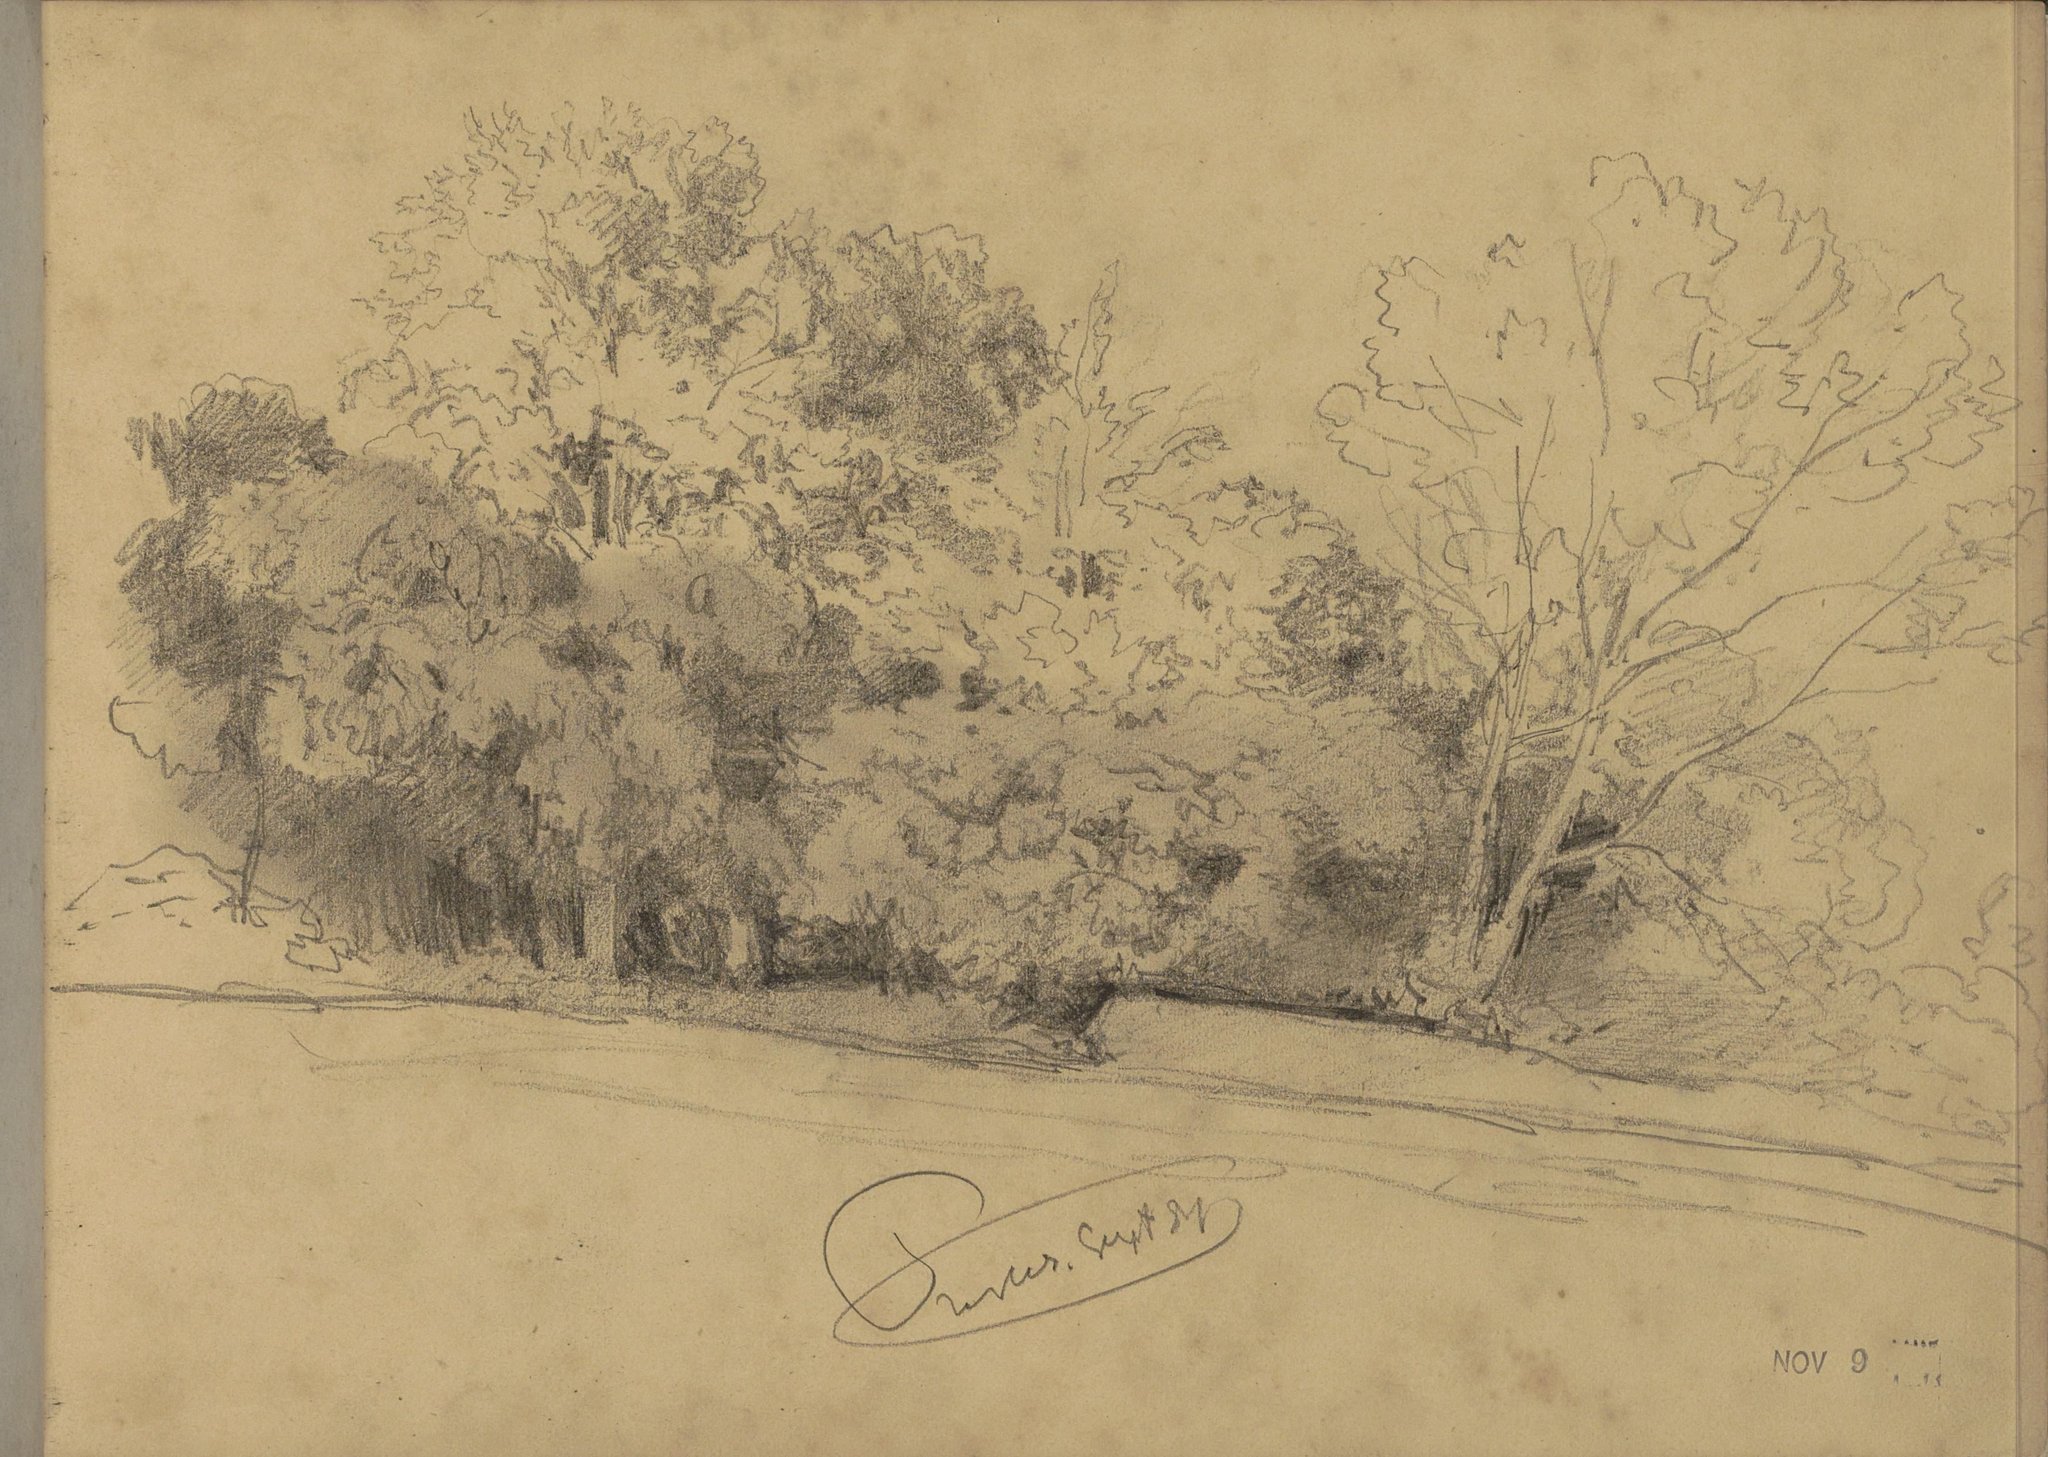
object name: sketchbook leaf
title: Bosrand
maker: willem roelofs (i)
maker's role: draughtsman, painter, print maker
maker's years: 1822-1897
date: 1809-1851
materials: paper, pencil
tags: fringe, edge of the wood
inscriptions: date and inscription: ‘Pre[...]. sept 51’, date: ‘NOV 9 , ,,’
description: Blad 4 recto uit een schetsboek met 25 bladen.